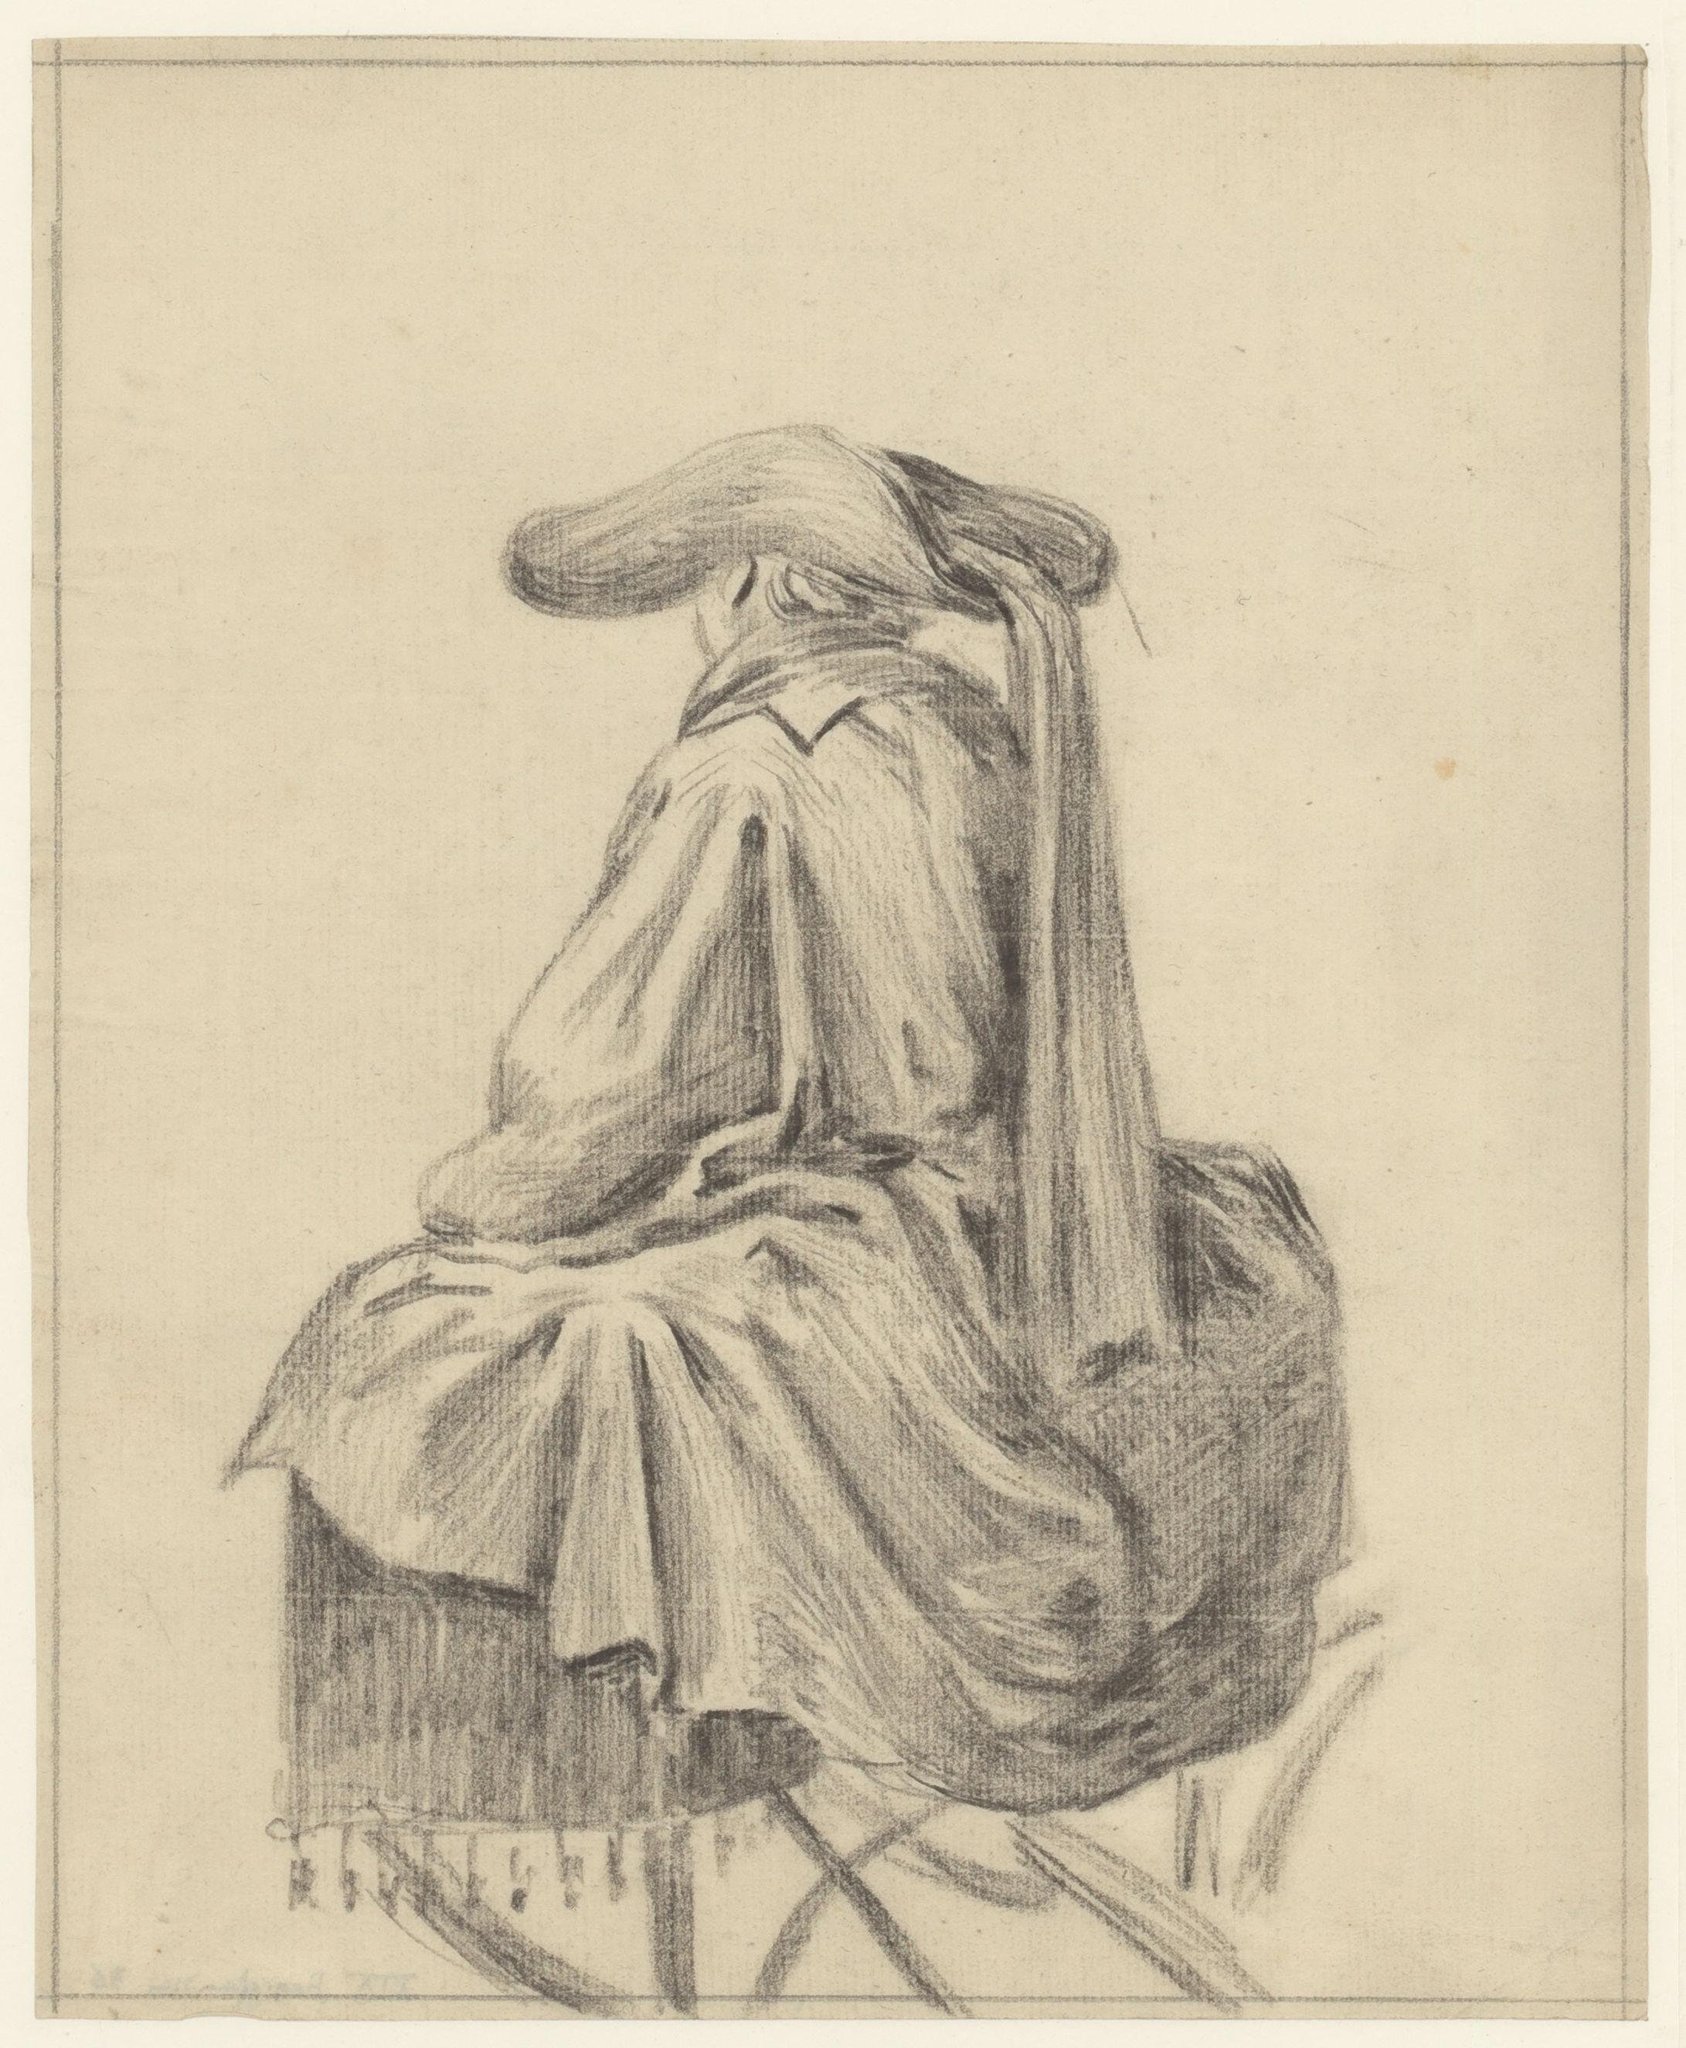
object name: drawing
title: Koetsier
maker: jean bernard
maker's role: draughtsman, print maker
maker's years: 1765-1833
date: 1780-1833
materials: chalk, paper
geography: netherlands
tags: hearse, funeral car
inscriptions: collector's mark: Lugt 1641, collector's mark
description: Een koetsier op de bok van een lijkwagen. Zittende man op de rug gezien. Onderwerpsrubrieken binnen de Atlas Zeden en Gewoonten: Des Menschen Begin, Midden en Einde. Begrafenissen, aansprekers, doodgravers, enz.